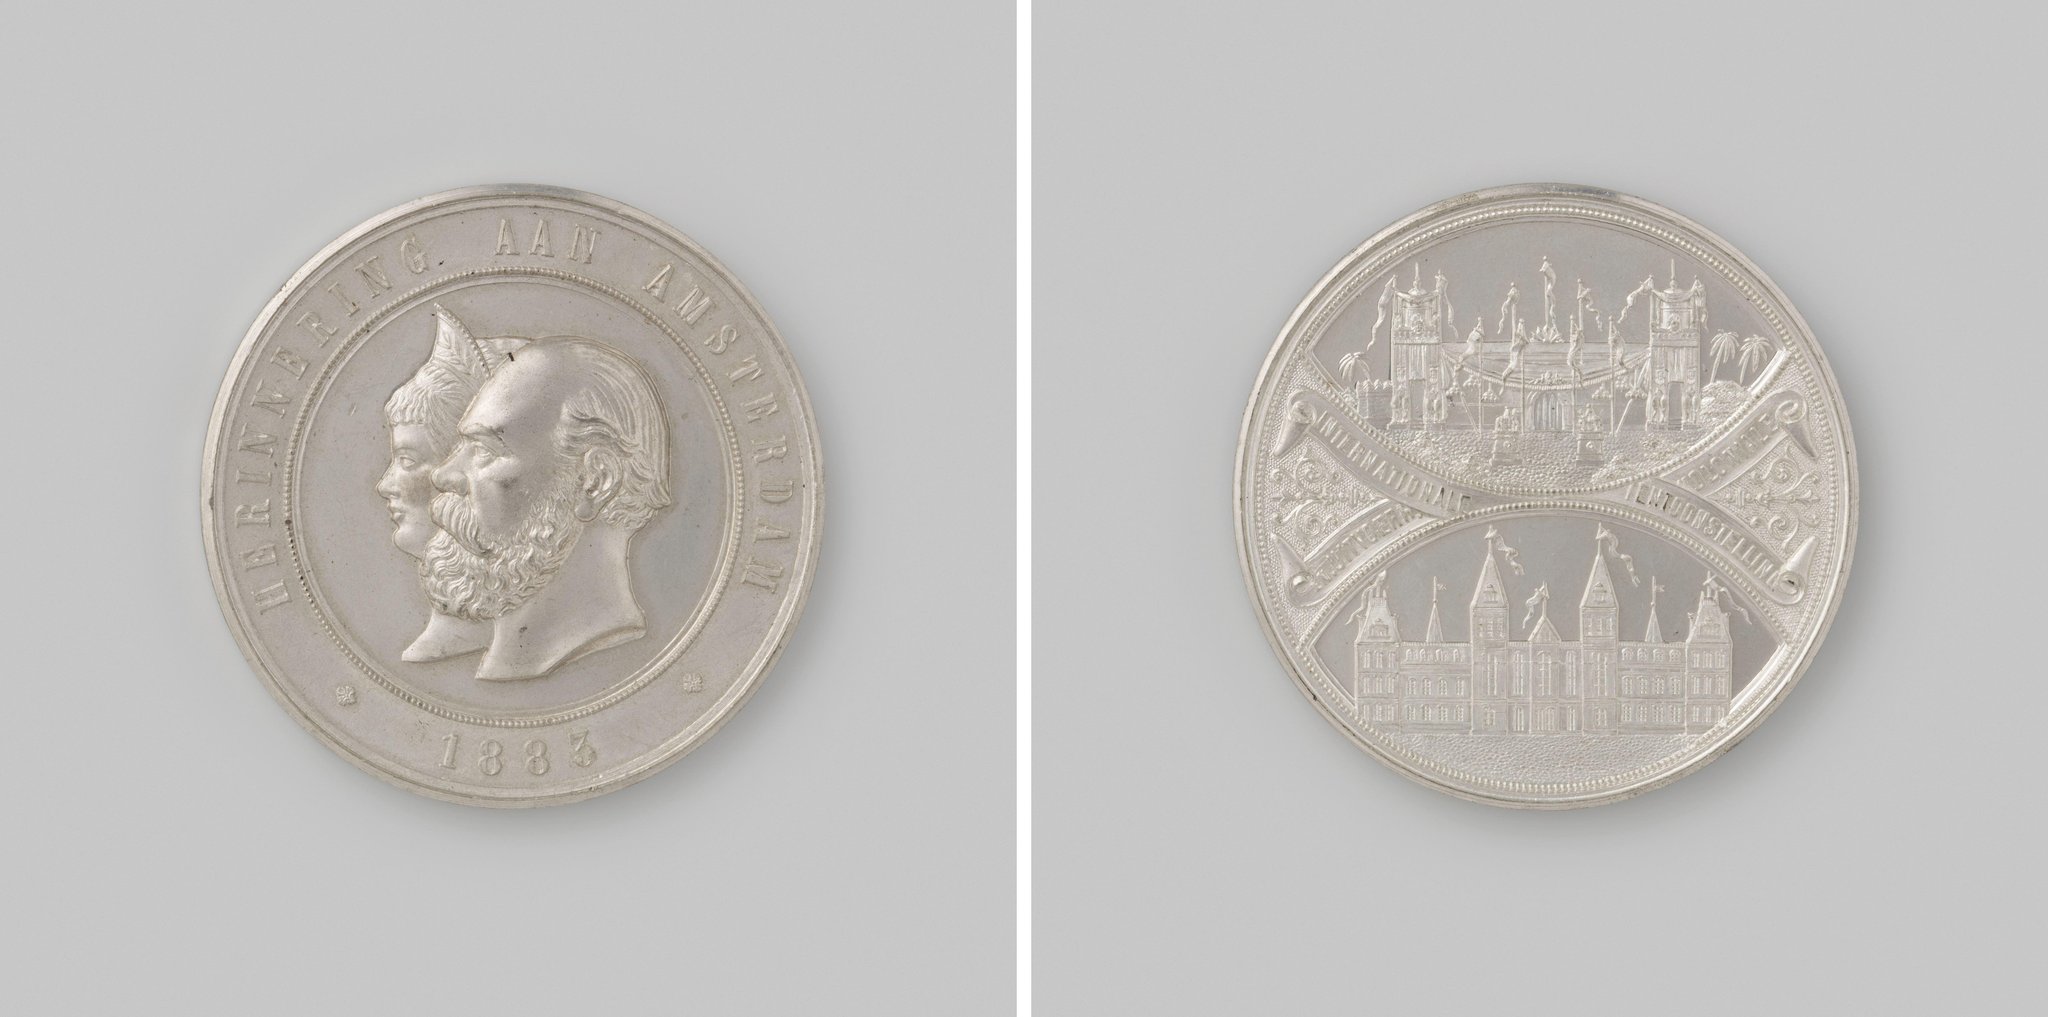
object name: history medal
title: Herinnering aan de Internationale Koloniale en Uitvoerhandel-Tentoonstelling te Amsterdam 1883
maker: e. mayer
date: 1883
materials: tin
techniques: striking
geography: stuttgart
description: Tinnen penning, op de voorzijde de geconjugeerde portretten van Koning Willem III en Koningin Emma naar links met omschrift, op de keerzijde boven elkaar twee ellipsvormige medaillons met het tentoonstellingsgebouw en het Rijksmuseum, waartussen een versierde ruimte met twee kruisende tekstlinten.